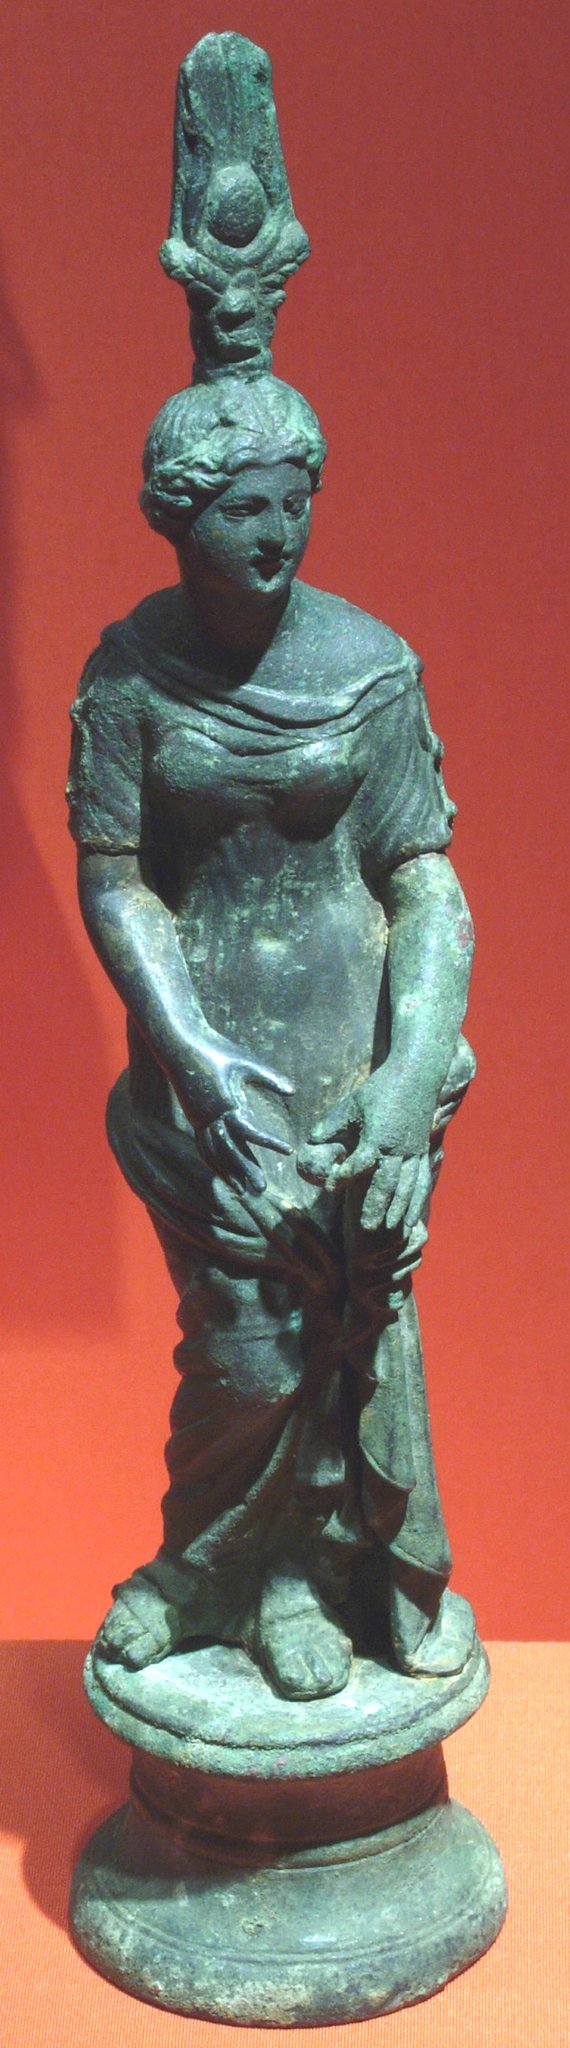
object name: statuette, isi aphrodite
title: Isis-Aphrodite clasping a garment rolled about her hips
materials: bronze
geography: egypt